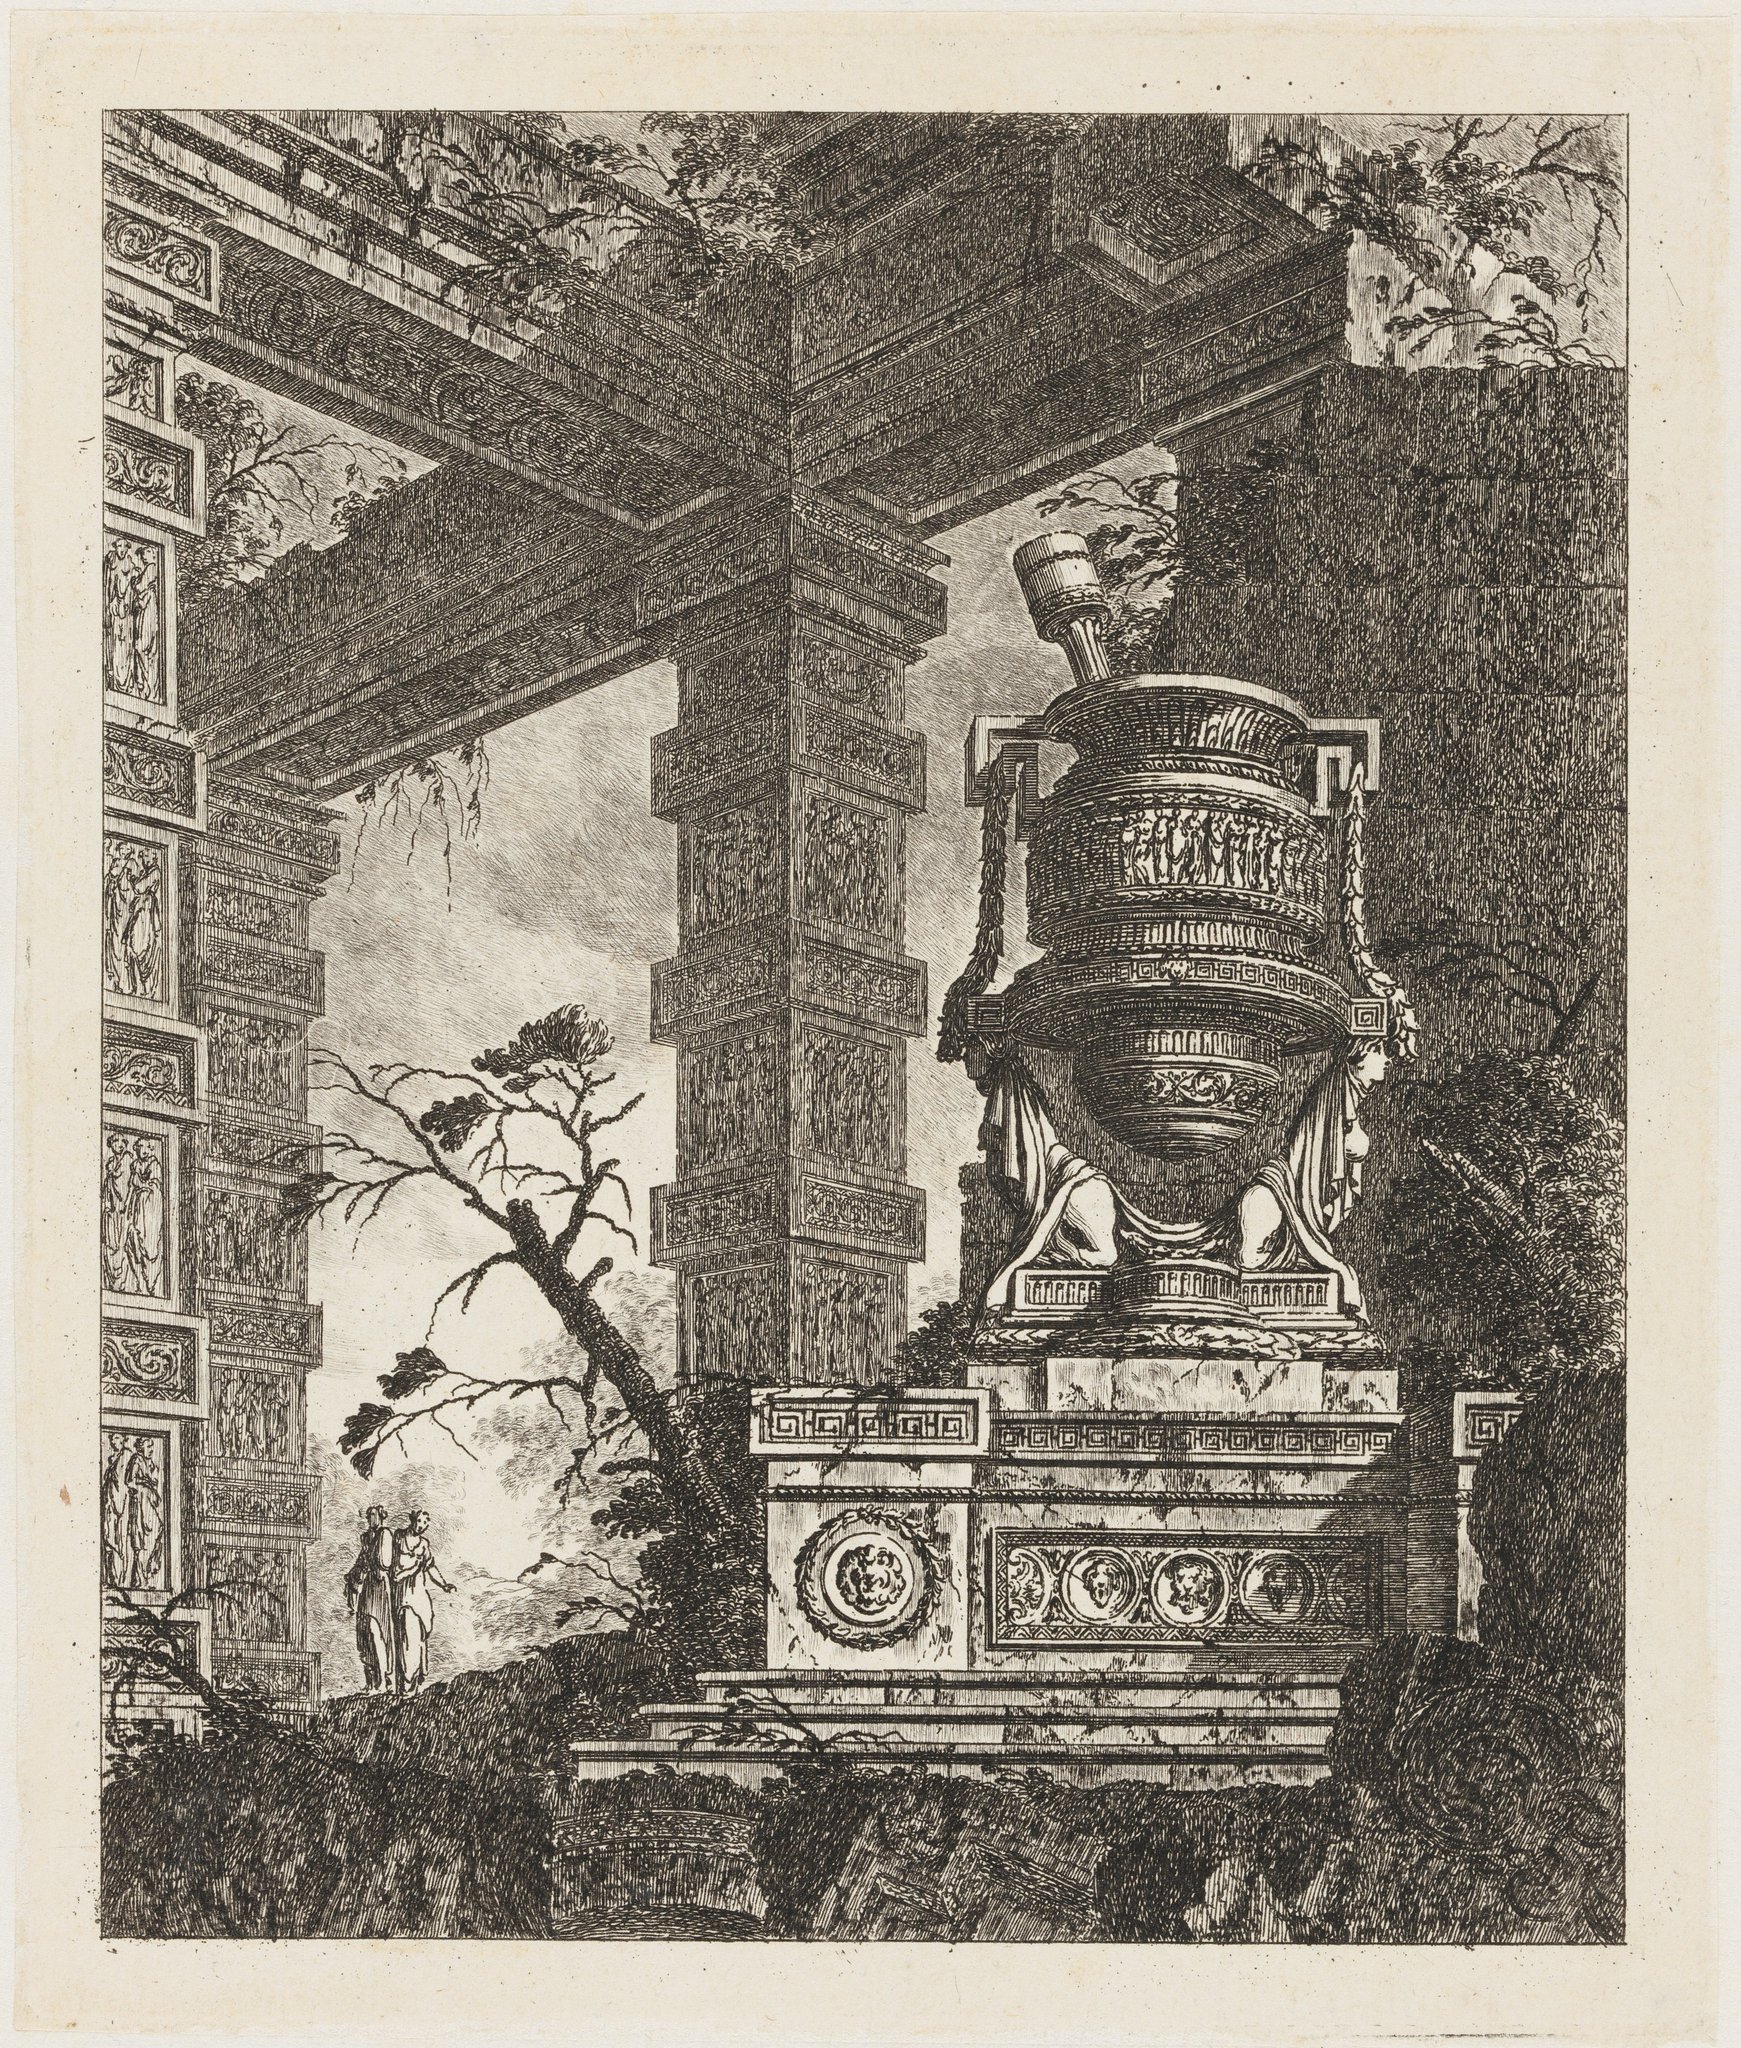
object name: book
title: Collection of Different Subjects of Vases, Tombs, Ruins and Fountains...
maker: jean laurent legeay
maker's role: artist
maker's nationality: french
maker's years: 1710-1788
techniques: etching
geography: france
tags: fountains,tombs,ruins,trees,vases